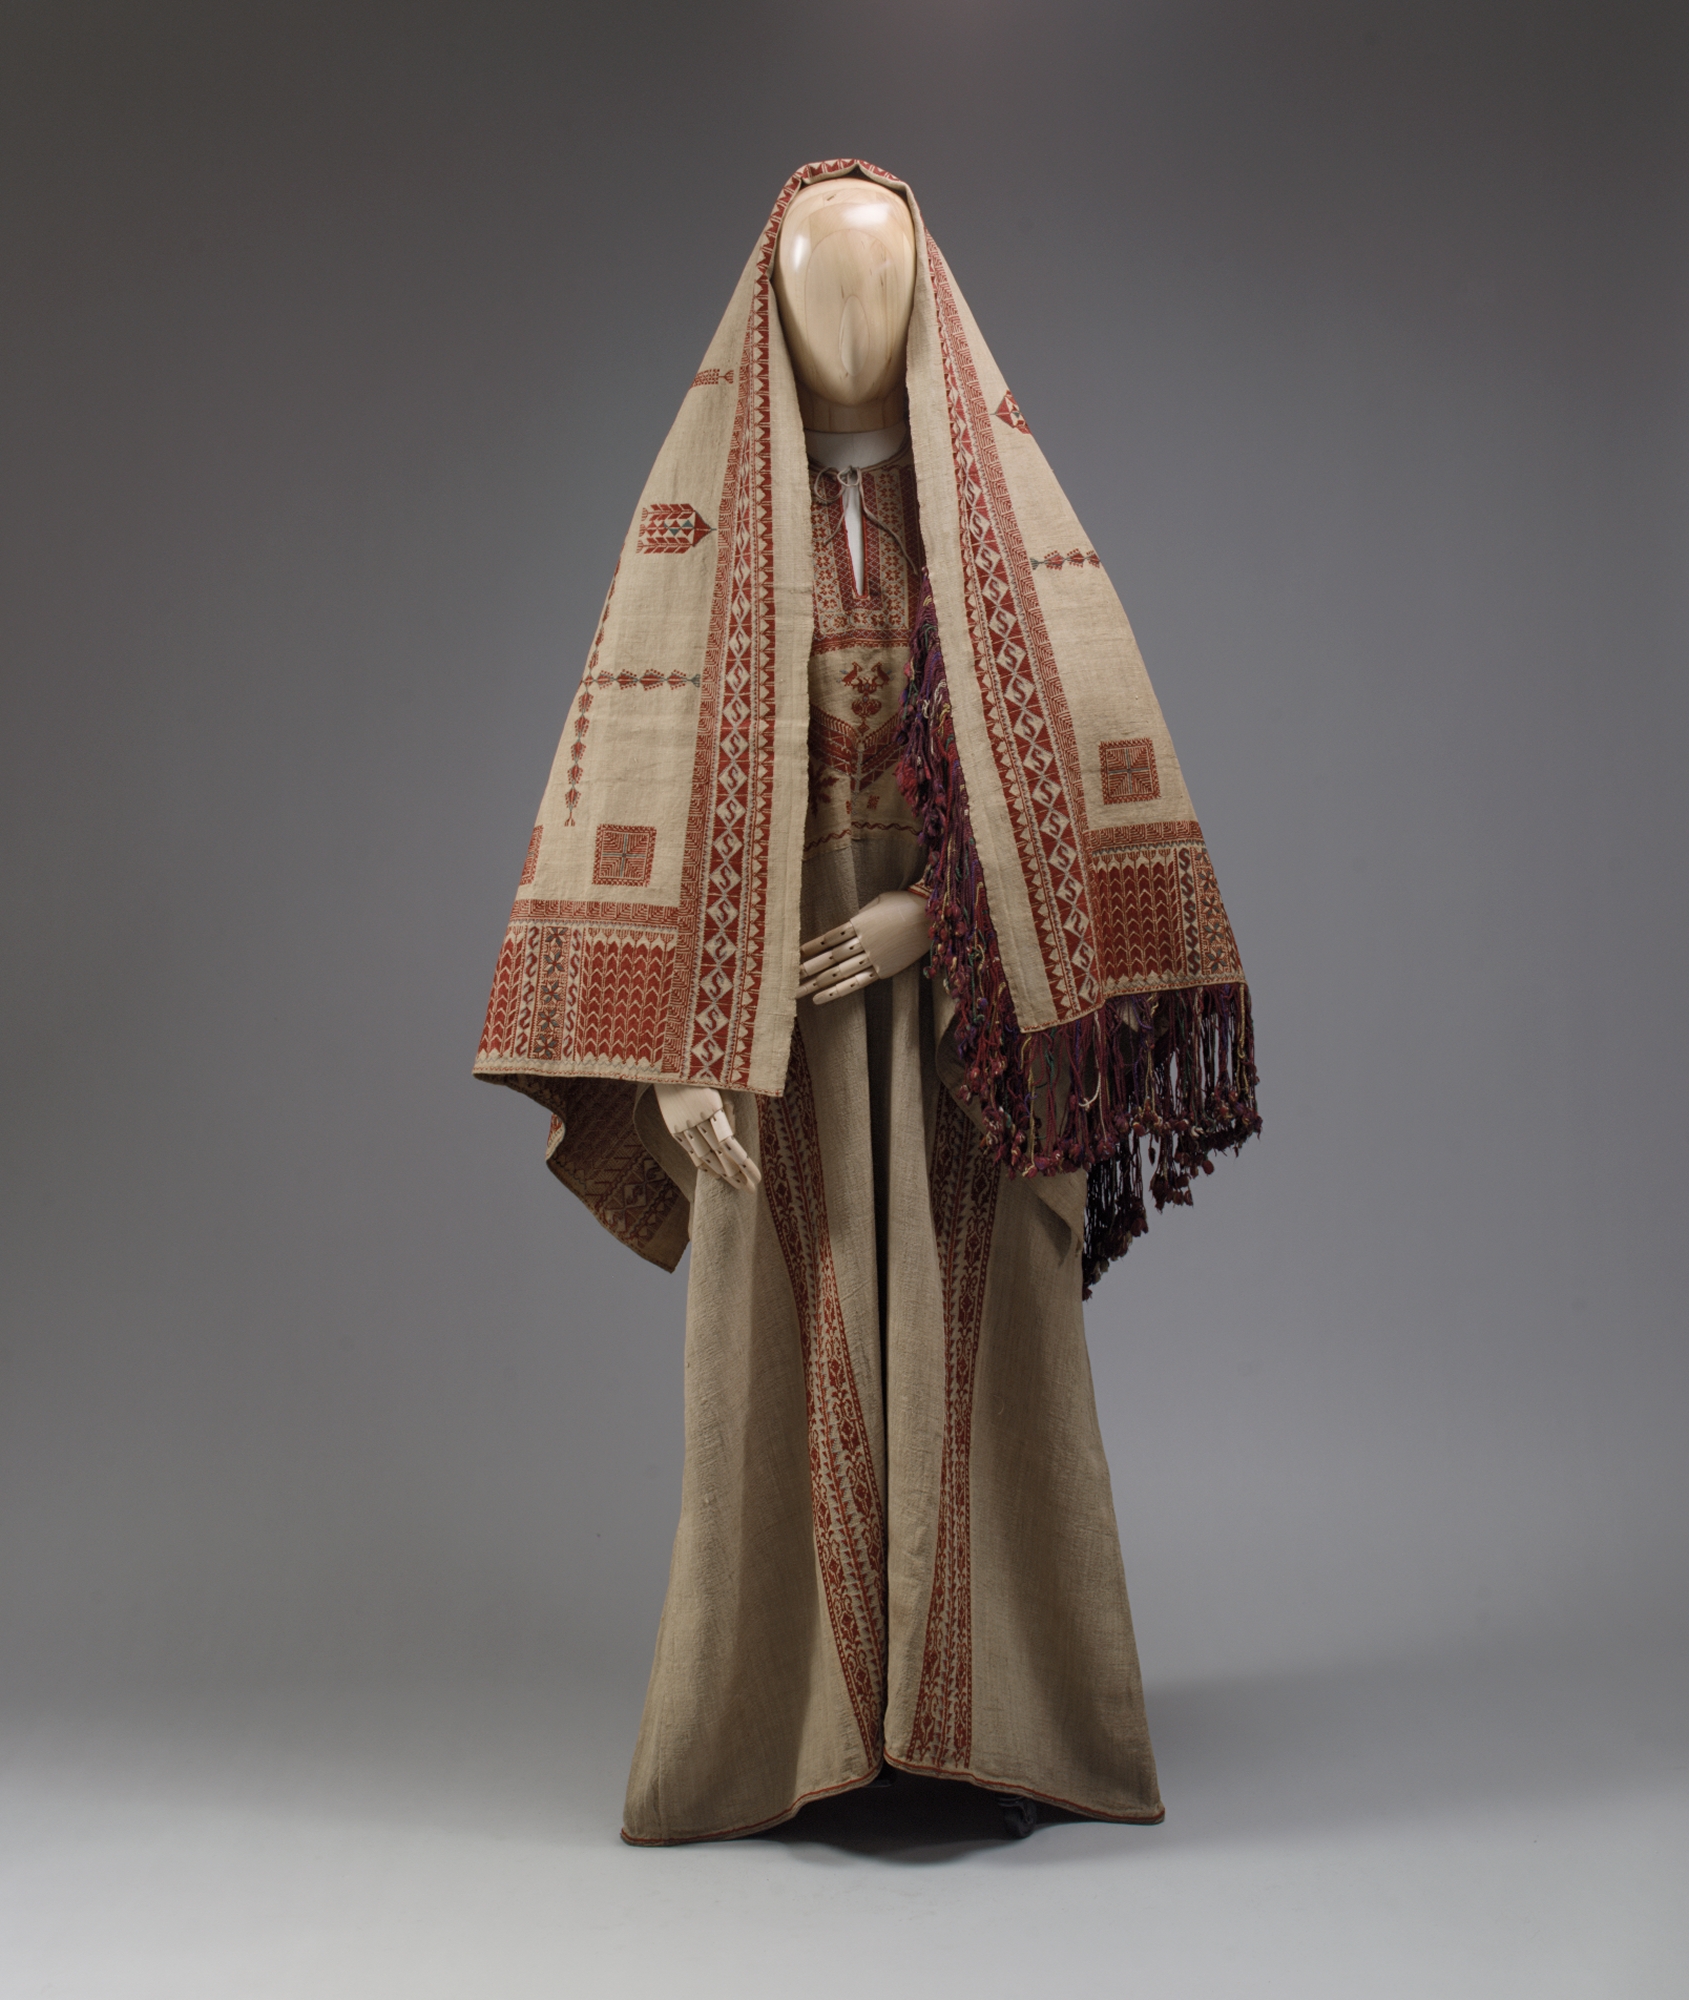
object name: ensemble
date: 1801-1900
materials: cotton, linen, metal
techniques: embroidery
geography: palestine